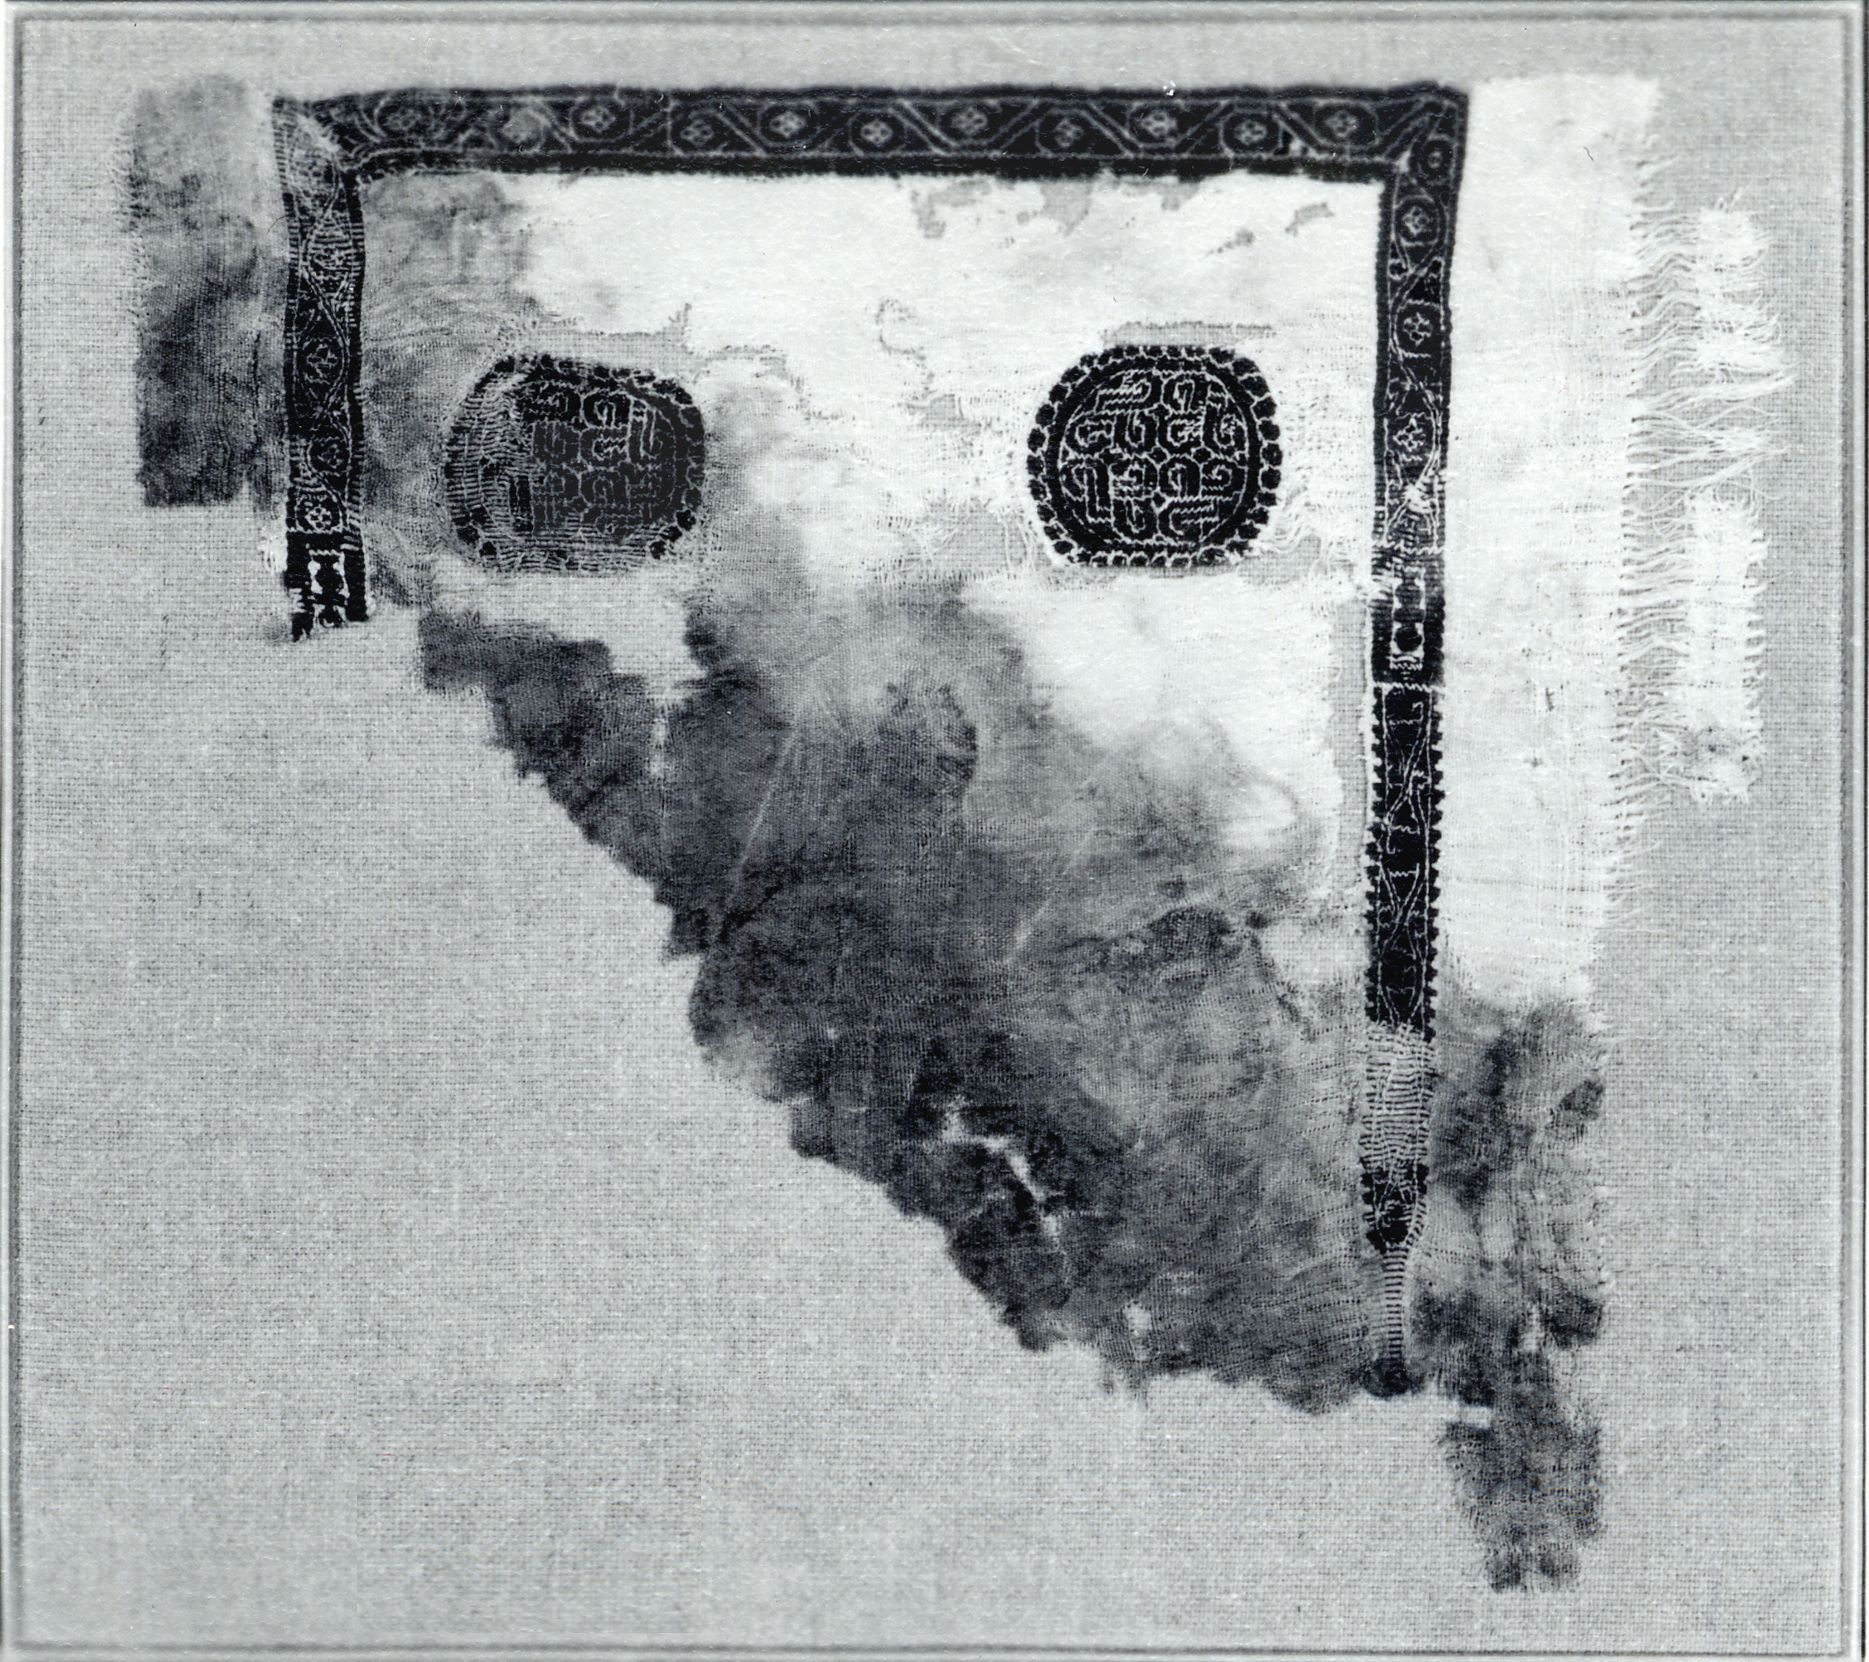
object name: fragment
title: Dress Fragment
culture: coptic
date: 301-400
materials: linen, wool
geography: egypt